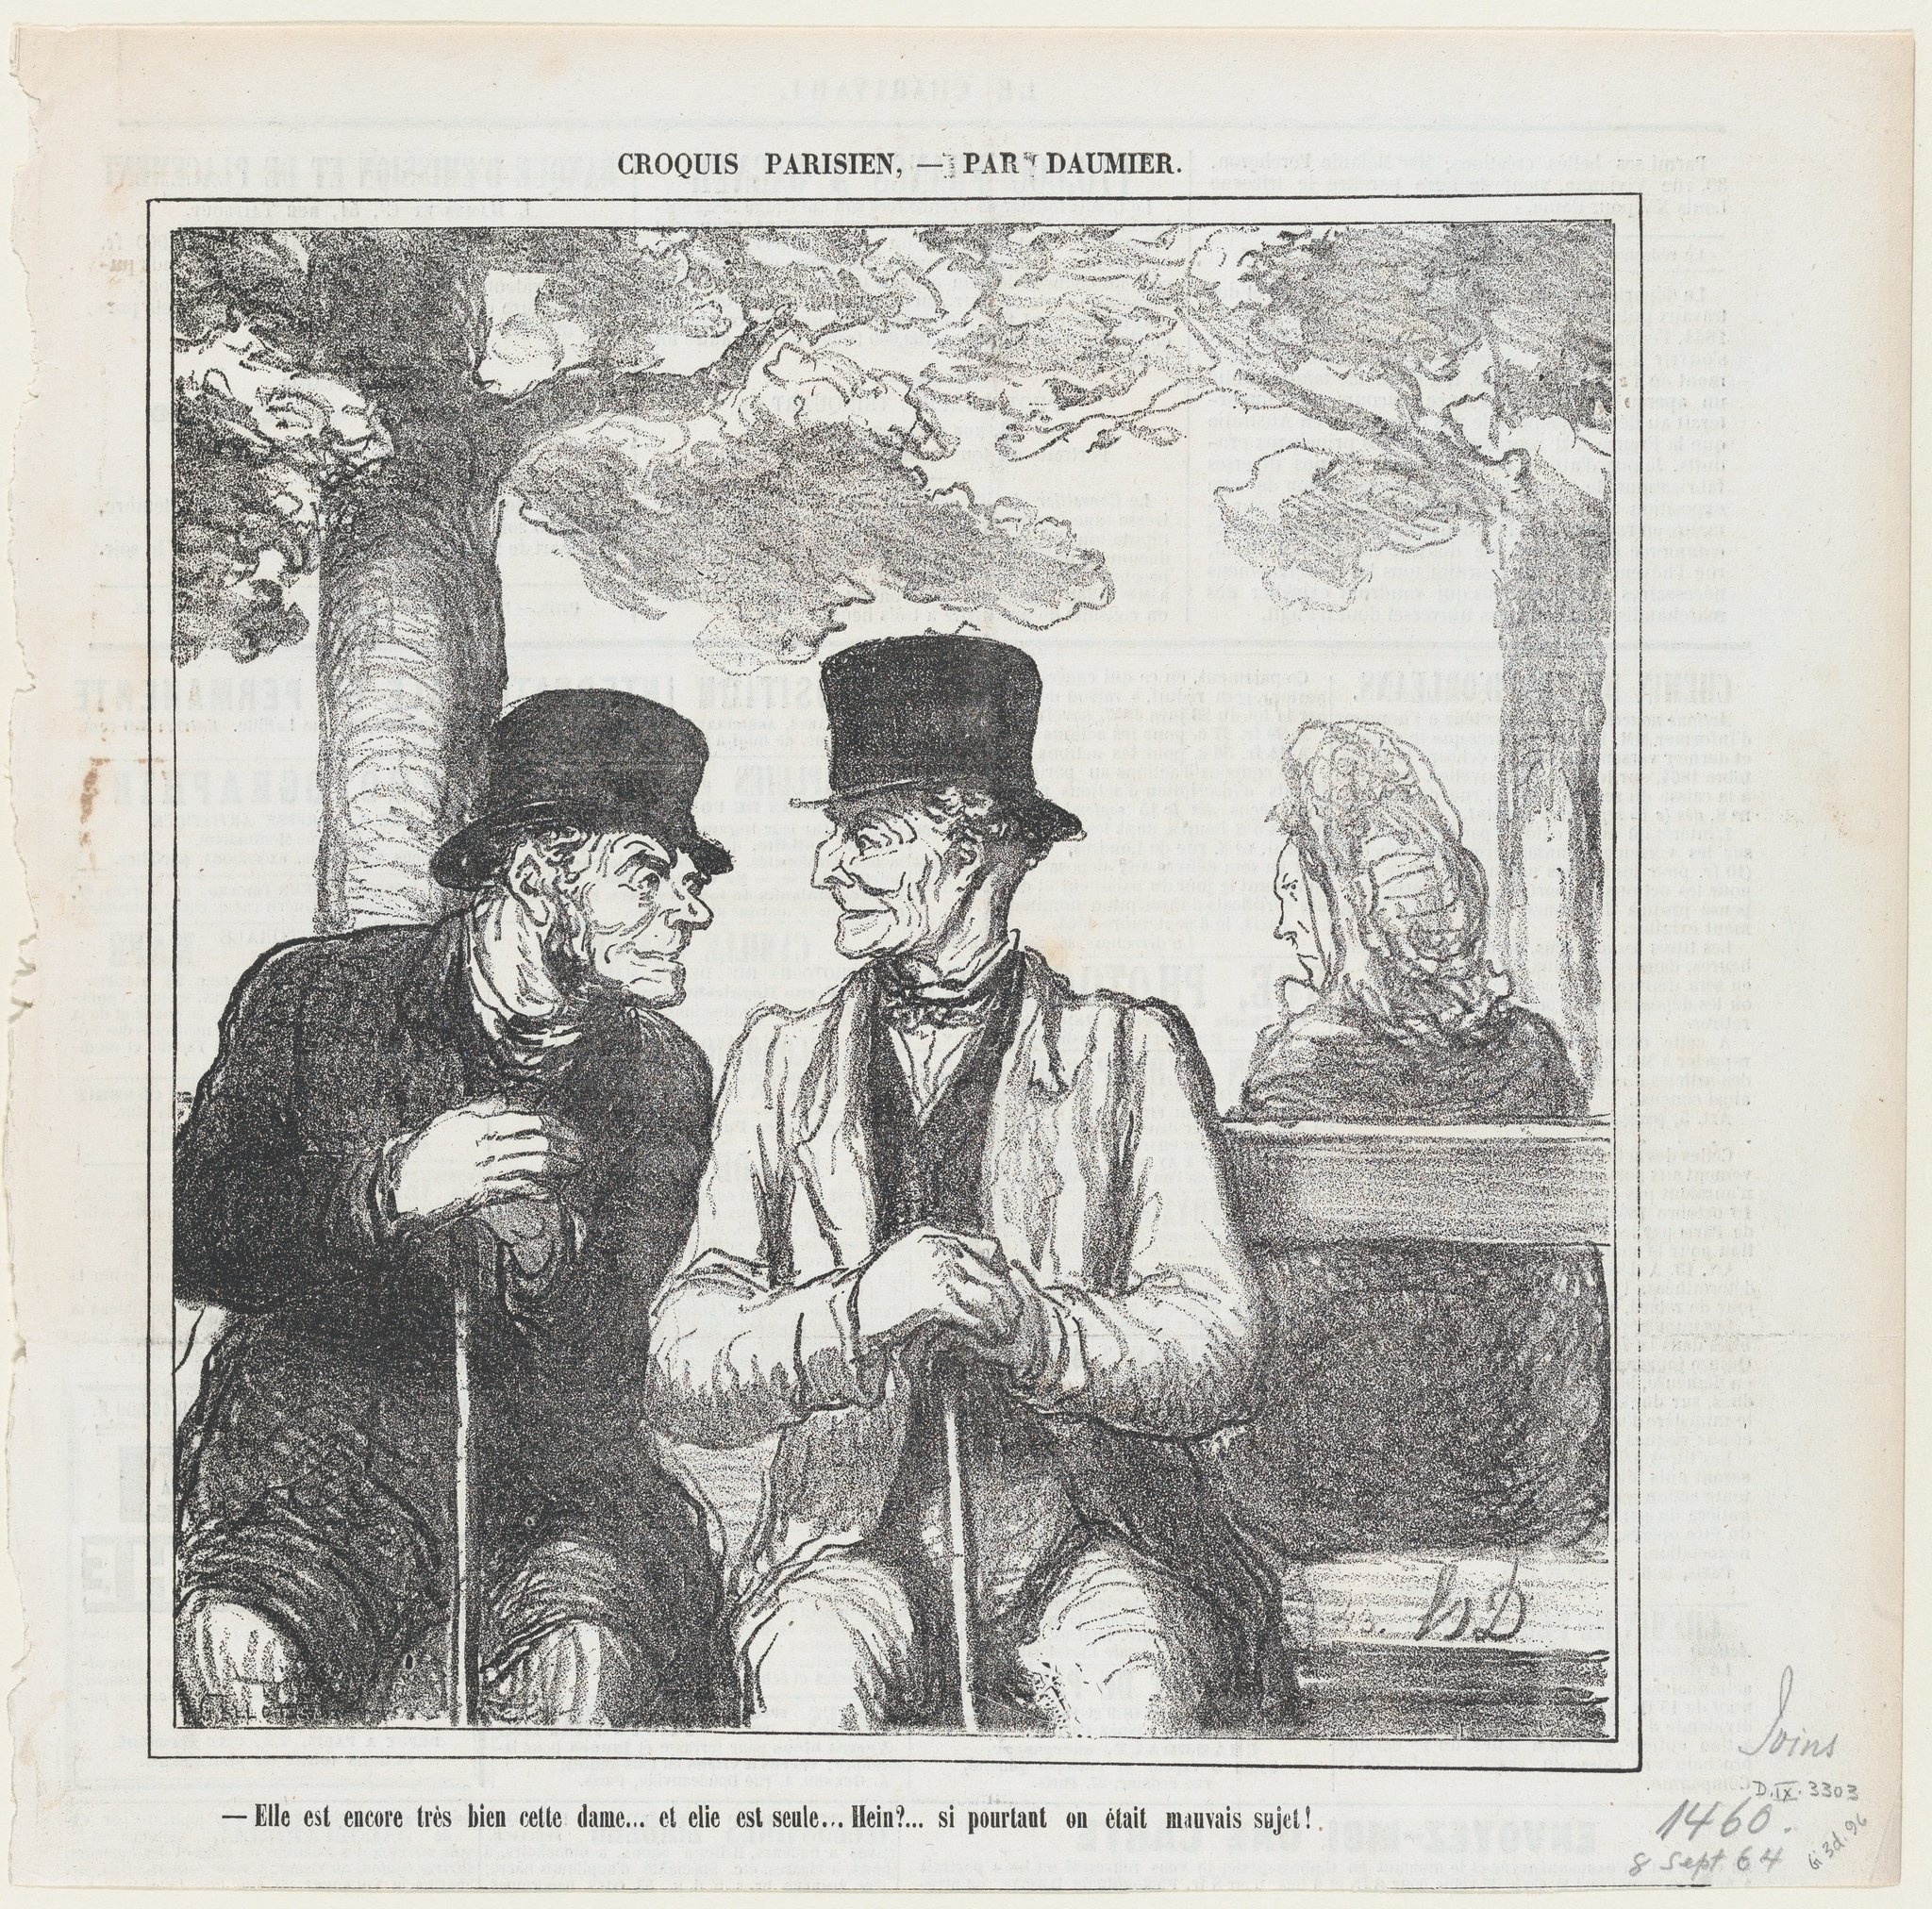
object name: print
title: Not bad, not bad at all the lady over there.... I wonder if she is alone... What rakes we are!, from 'Parisian sketches,' published in Le Charivari, September 8, 1864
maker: honoré daumier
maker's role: artist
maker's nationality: french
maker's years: 1808-1879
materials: paper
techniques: lithograph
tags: satire,men,women